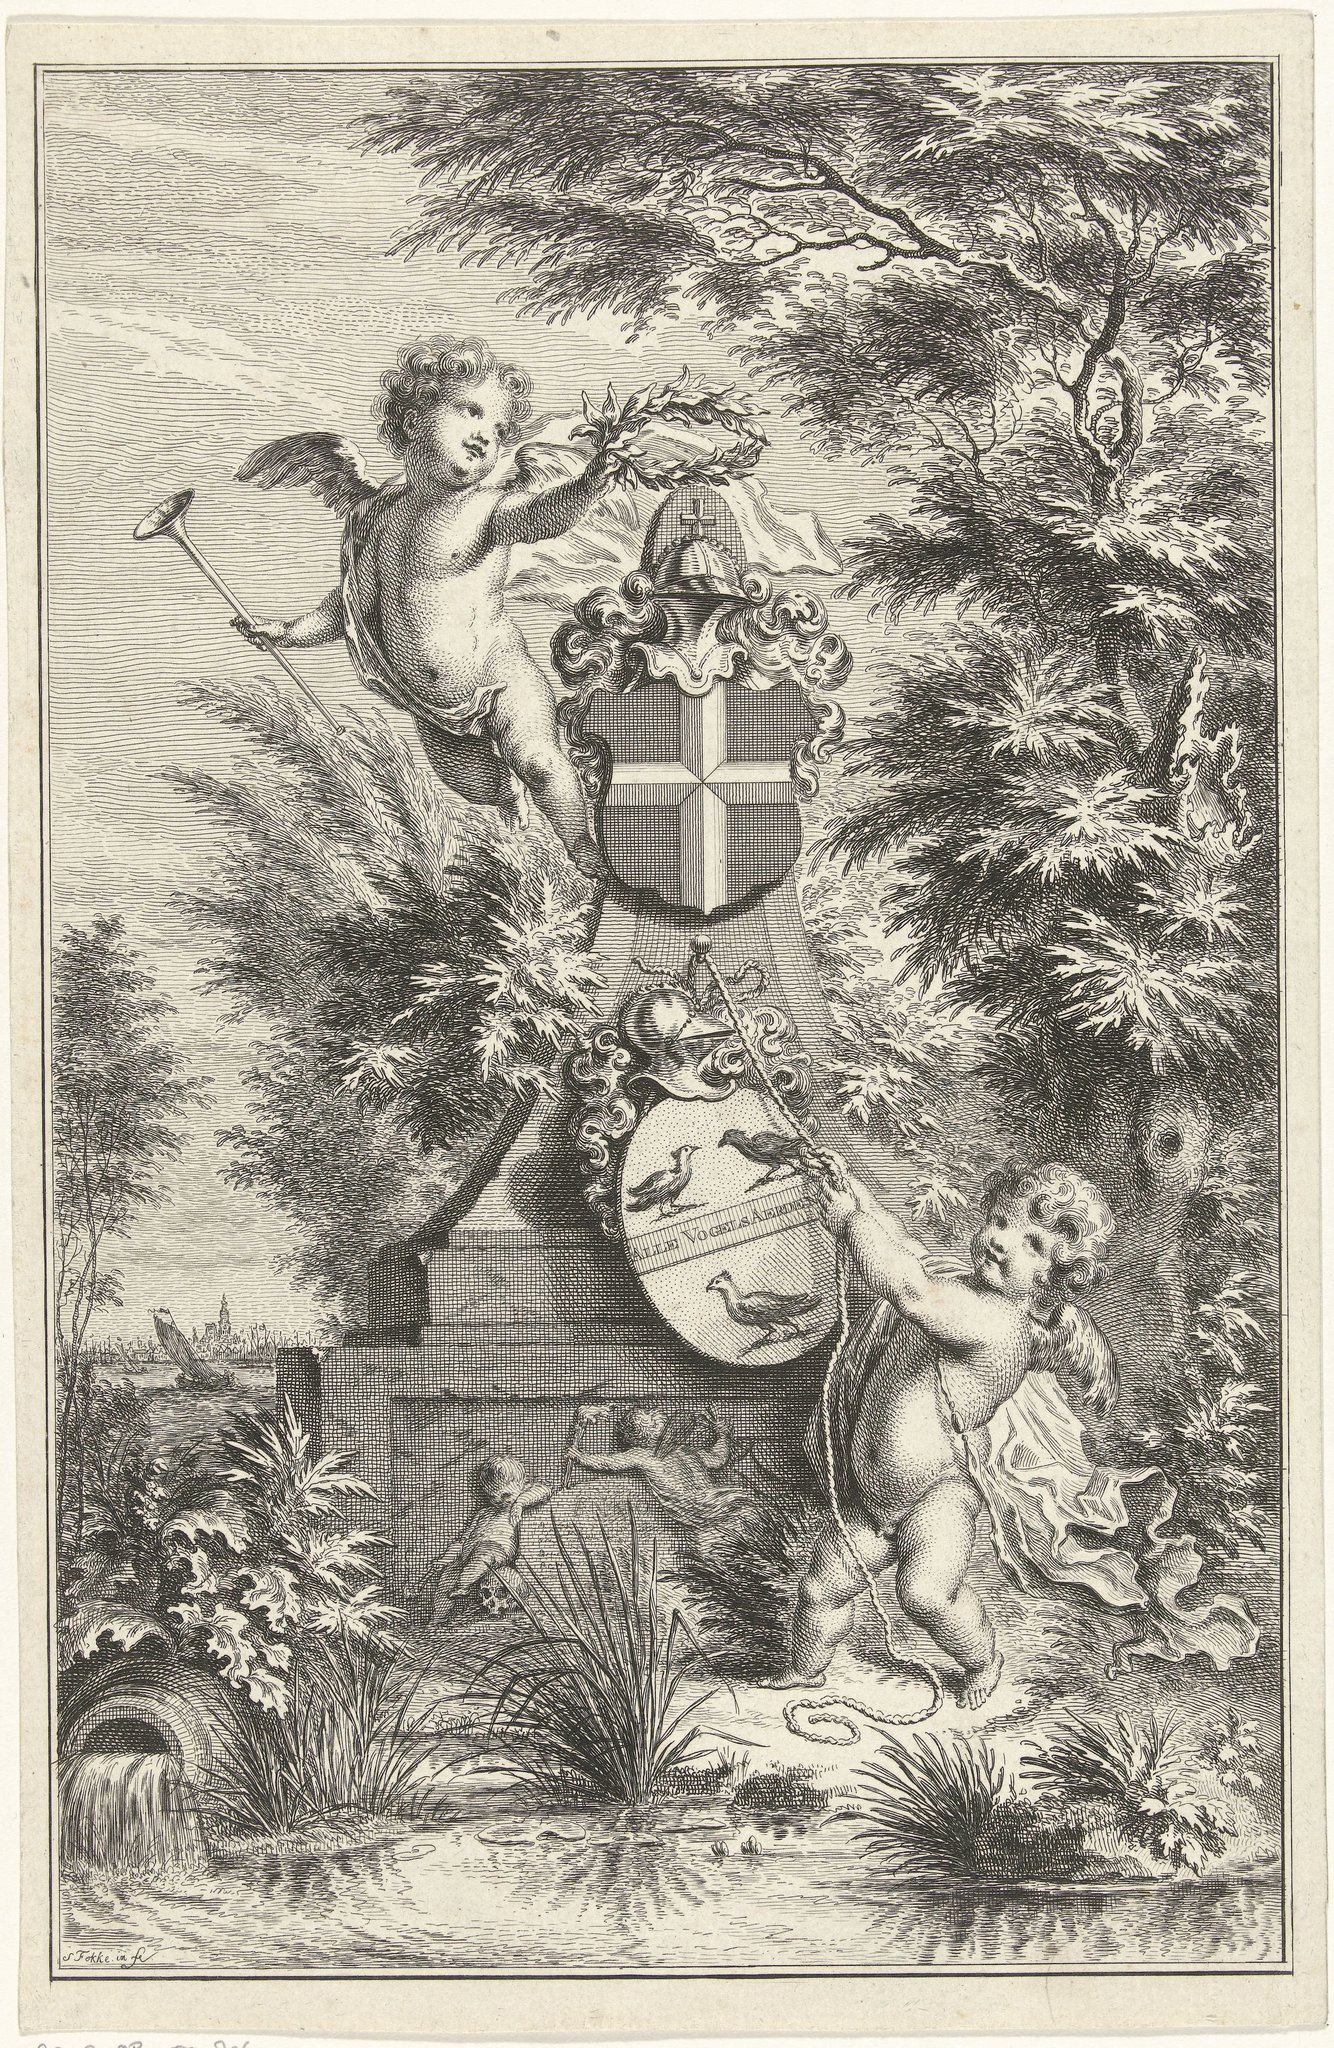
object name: print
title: Allegorisch gedenkteken met gehelmde wapenschilden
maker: simon fokke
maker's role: draughtsman, print maker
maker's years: 1712-1784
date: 1722-1784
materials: paper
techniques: etching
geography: amsterdam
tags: other memorial structures, cupids: 'amores', 'amoretti', 'putti'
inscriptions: collector's mark: Lugt 2228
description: Twee putti bij een gedenkteken. De vliegende putto met bazuin in de hand lauwert het wapenschild met kruis op de top. De tweede putto hijst met een touw een wapen met drie vogels en het devies "alle vogels aerden" op het gedenkteken.